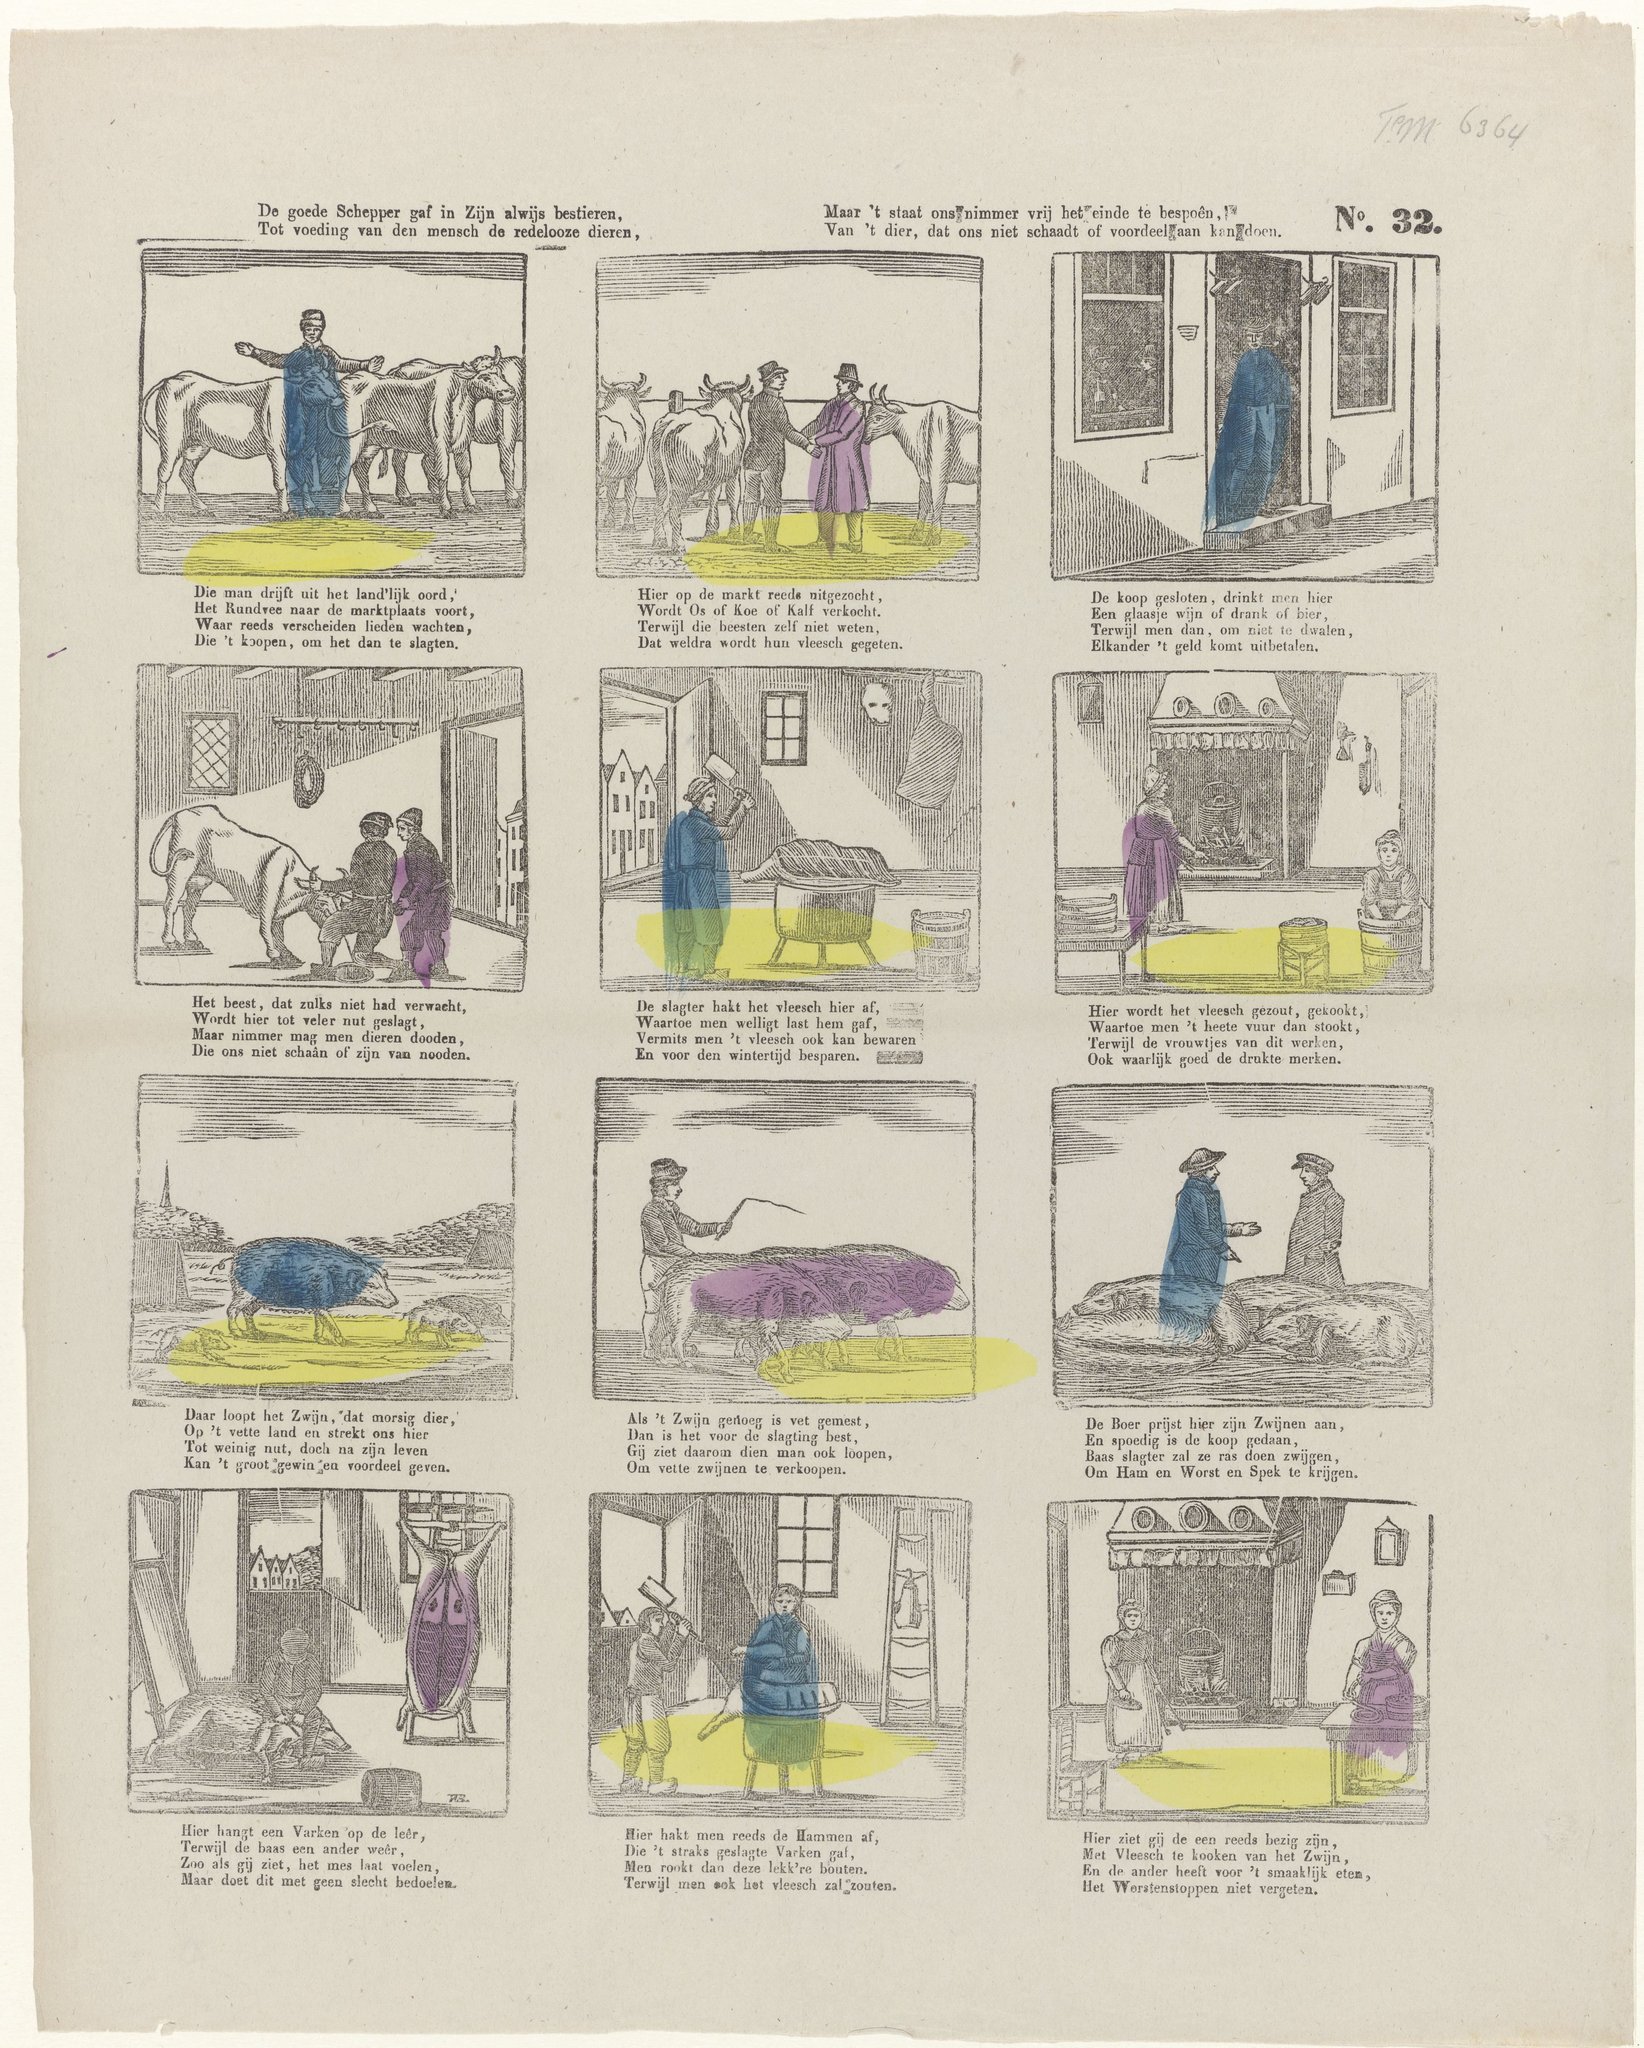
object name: popular print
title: De goede Schepper gaf in Zijn alwijs bestieren, / Tot voeding van den mensch de redelooze dieren (...)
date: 1850-1870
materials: paper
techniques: colour, letterpress printing, engraving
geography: netherlands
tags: slaughtered ox or pig, butcher, slaughterman, cattle-breeding, livestock industry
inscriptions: collector's mark: Lugt 2228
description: Blad met twaalf voorstellingen van het fokken en slachten van runderen en varkens. Onder elk plaatje een vierregelig versje. Genummerd rechtsboven: No. 32. Ca. 1800-1850.